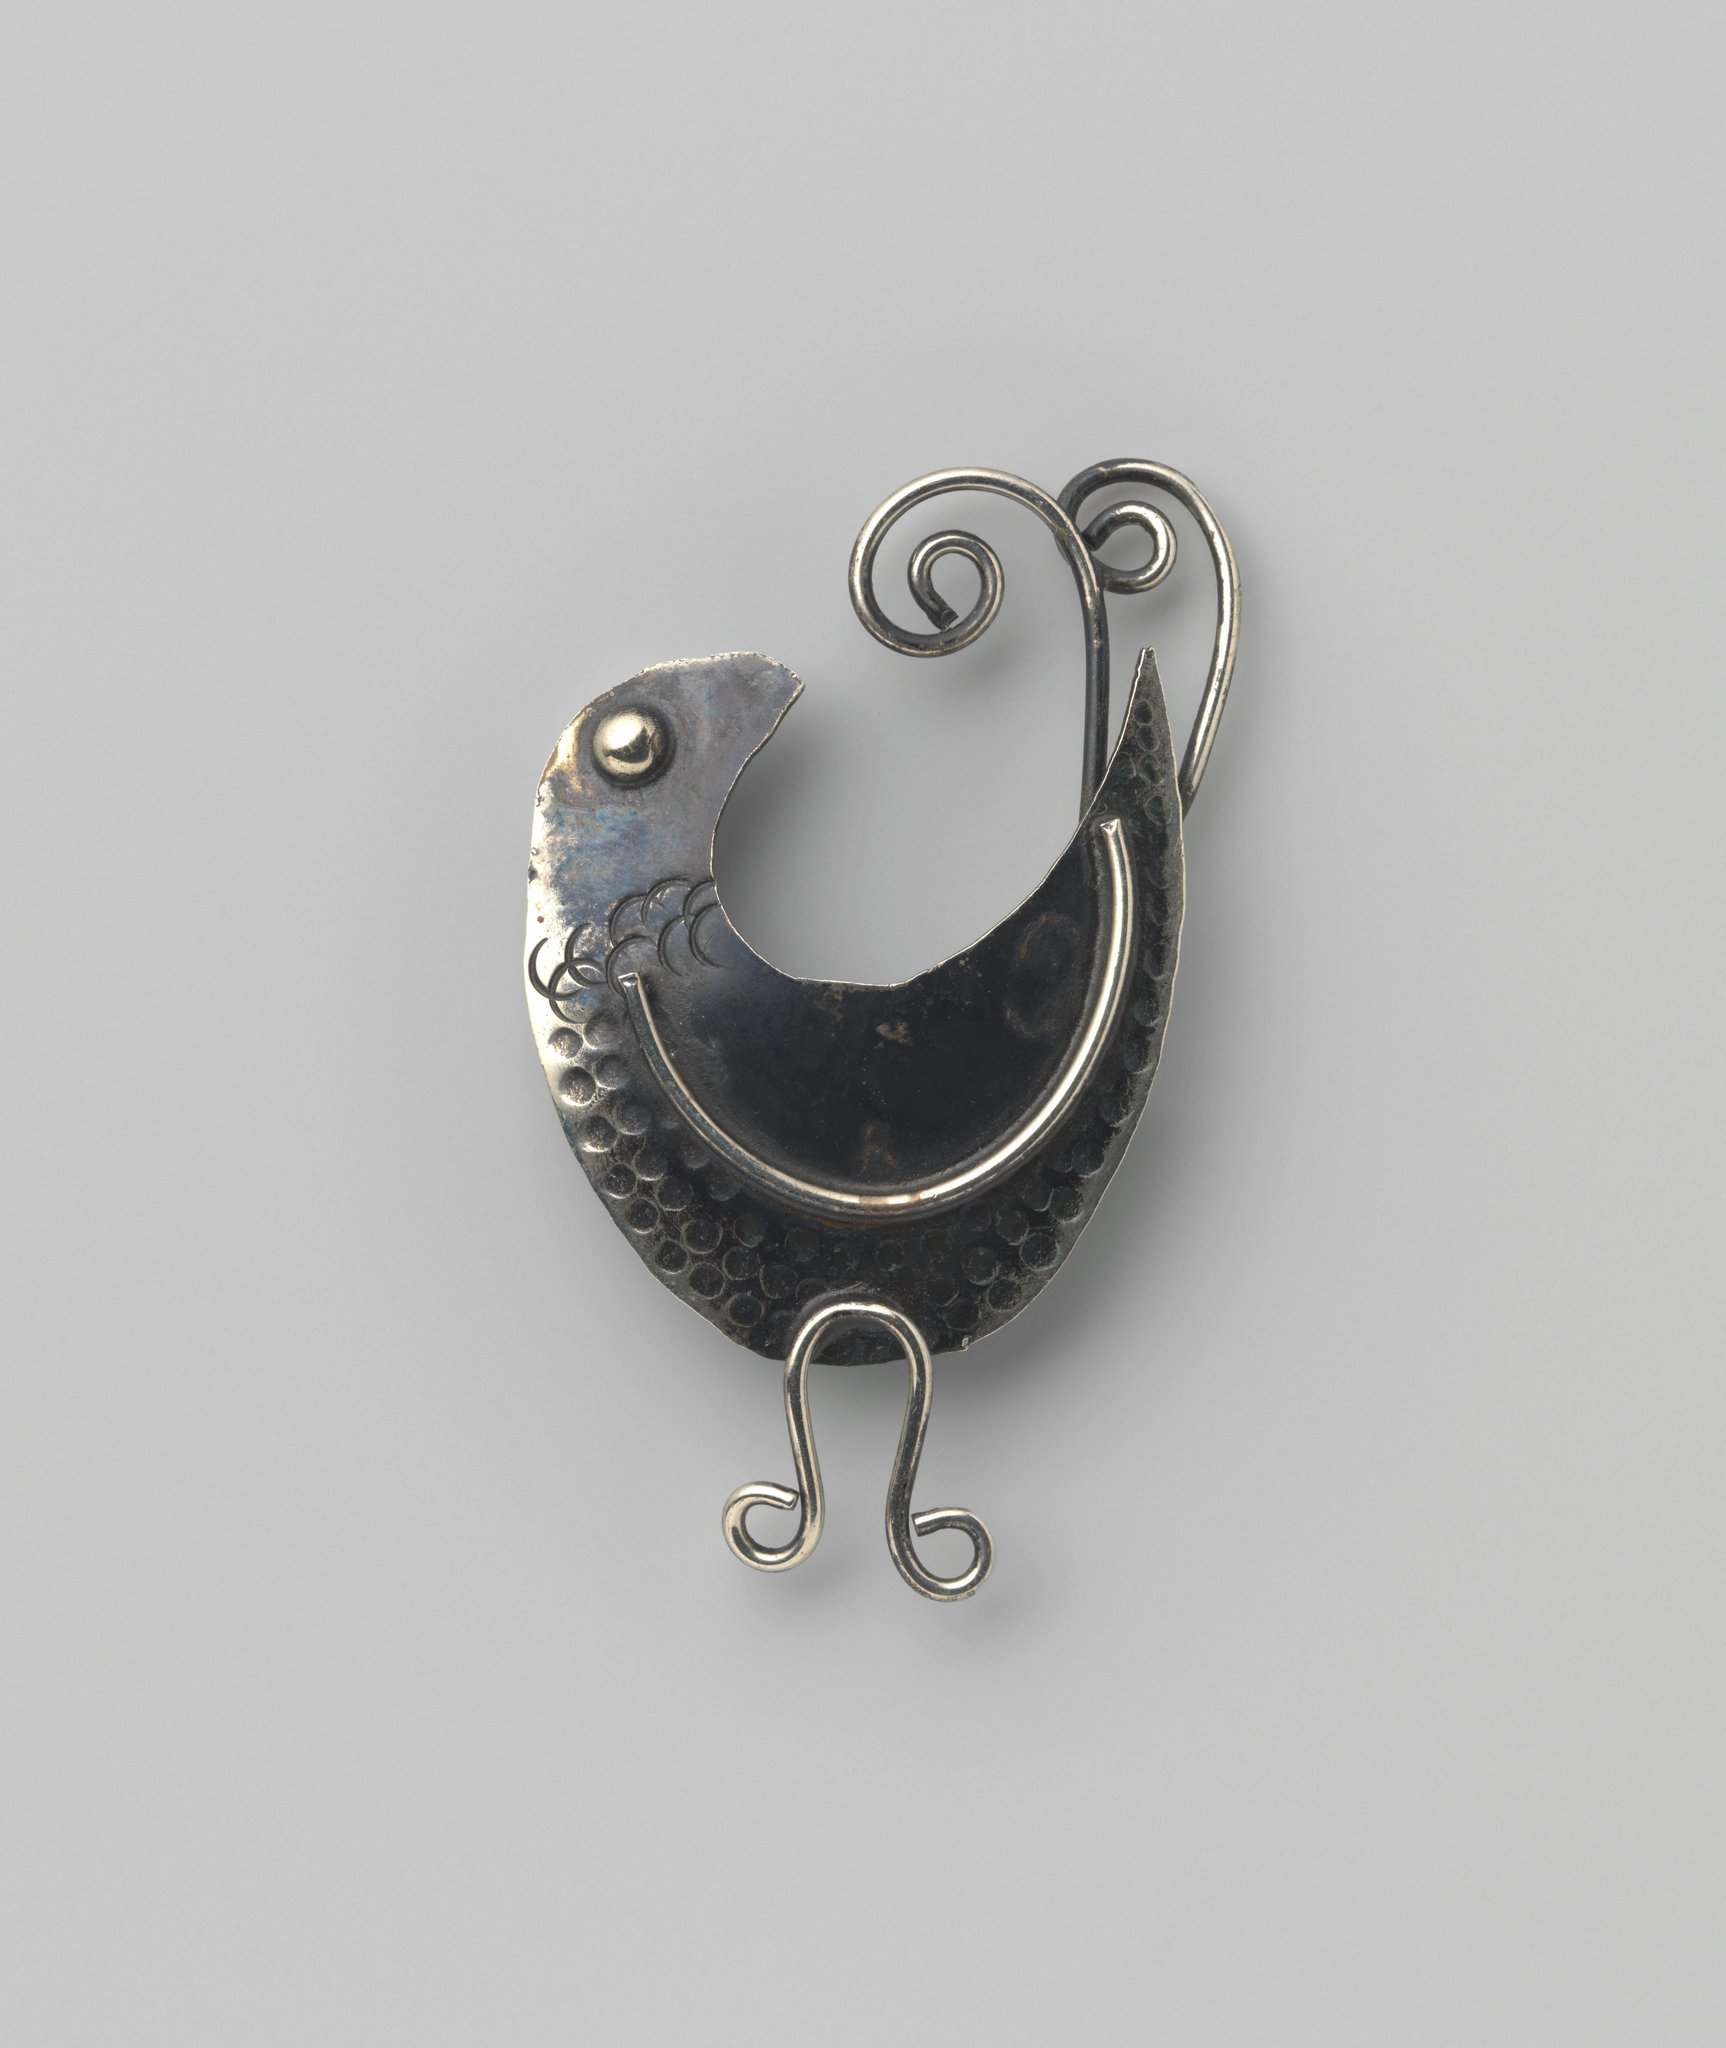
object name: brooch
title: Broche van zilverkleurig metaal in de vorm van een vogel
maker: Anonymous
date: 1950-1970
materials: metal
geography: netherlands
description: Broche van gezwart zilverkleurig metaal met draadwerk in de vorm van een vogel. Met draadwerk zijn de poten en de staart van het dier aangegeven. Het oog bestaat uit een poli bolling. De broche kan worden bevestigd met een veiligheidsspeld.